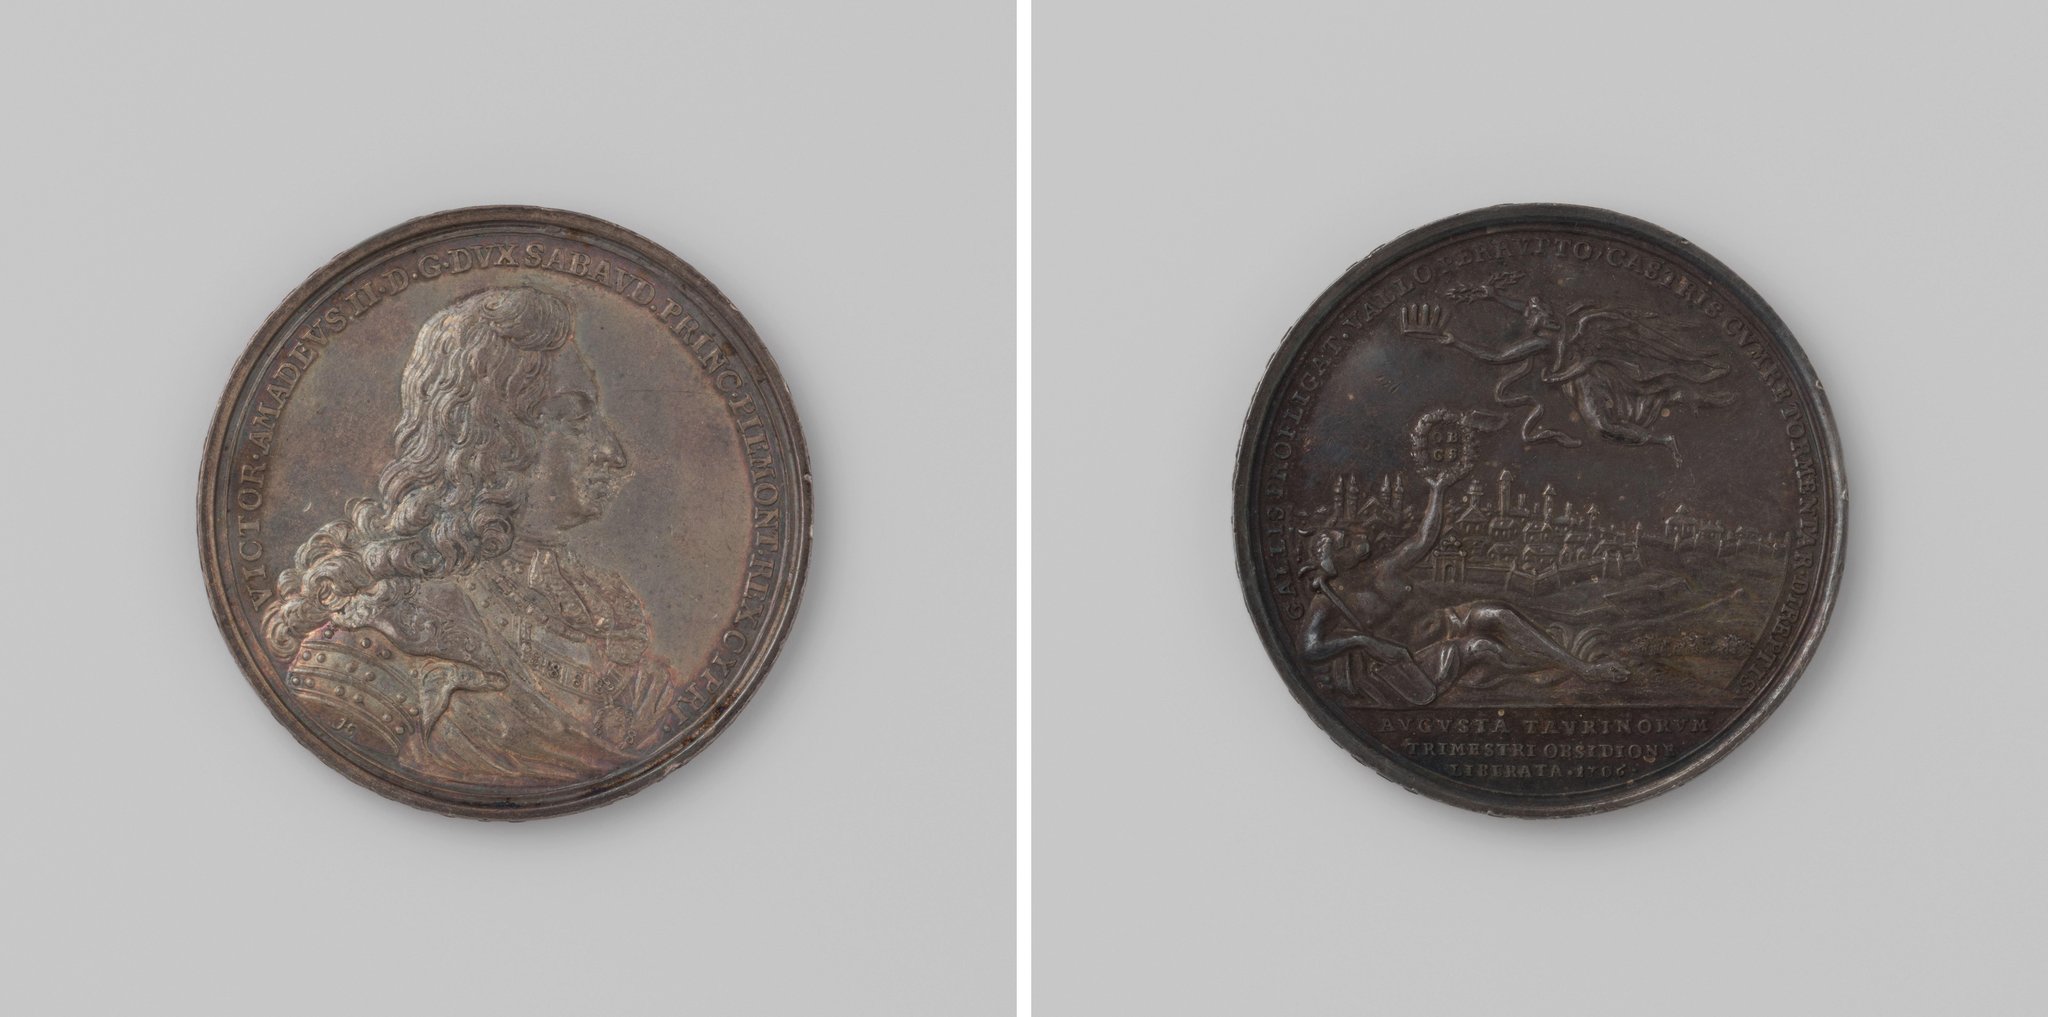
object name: history medal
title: Ontzet van Turijn en bevrijding van Savoye, ter ere van Victor Amadaeus II, hertog van Savoye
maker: georg hautsch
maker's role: medailleur, muntmaker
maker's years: 1679-1745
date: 1706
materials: silver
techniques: striking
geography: nuremberg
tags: victor amadeus ii (hertog van savoye), piemonte, savoye, turijn, ontzet van turijn (1706), bevrijding van savoye